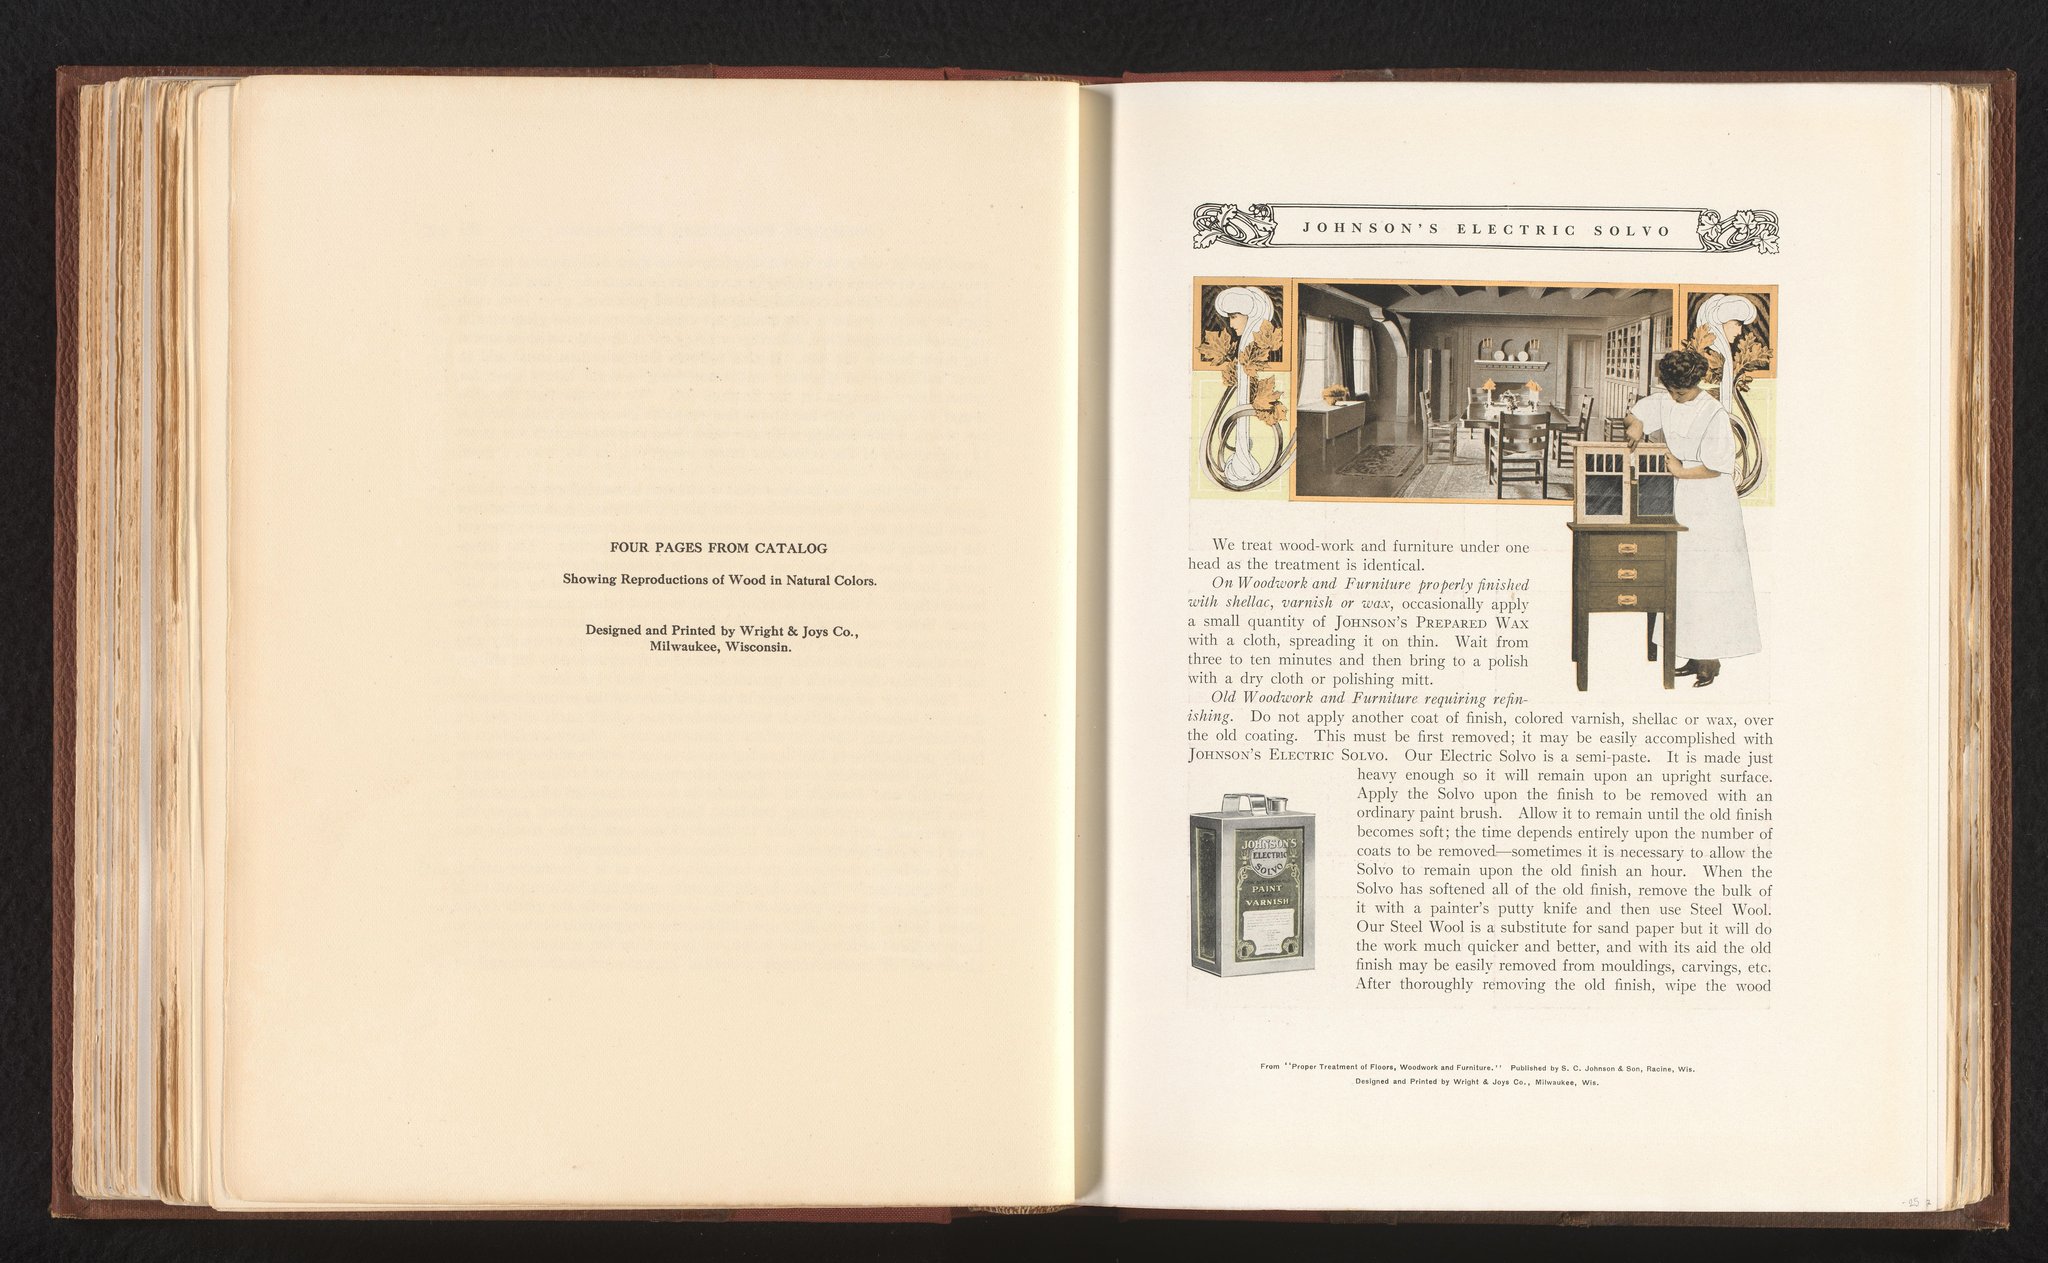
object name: photomechanical print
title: Reclame voor 'Johnson's Electric Solvo', uit de catalogus 'Proper Treatment of Floor, Woodwork and Furniture' gepubliceerd door S.C. Johnson & Son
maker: Anonymous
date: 1904-1909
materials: paper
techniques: three-color autotype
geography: milwaukee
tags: advertising, furniture and household effects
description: Prent op tweede ongenummerde pagina na pagina 201.